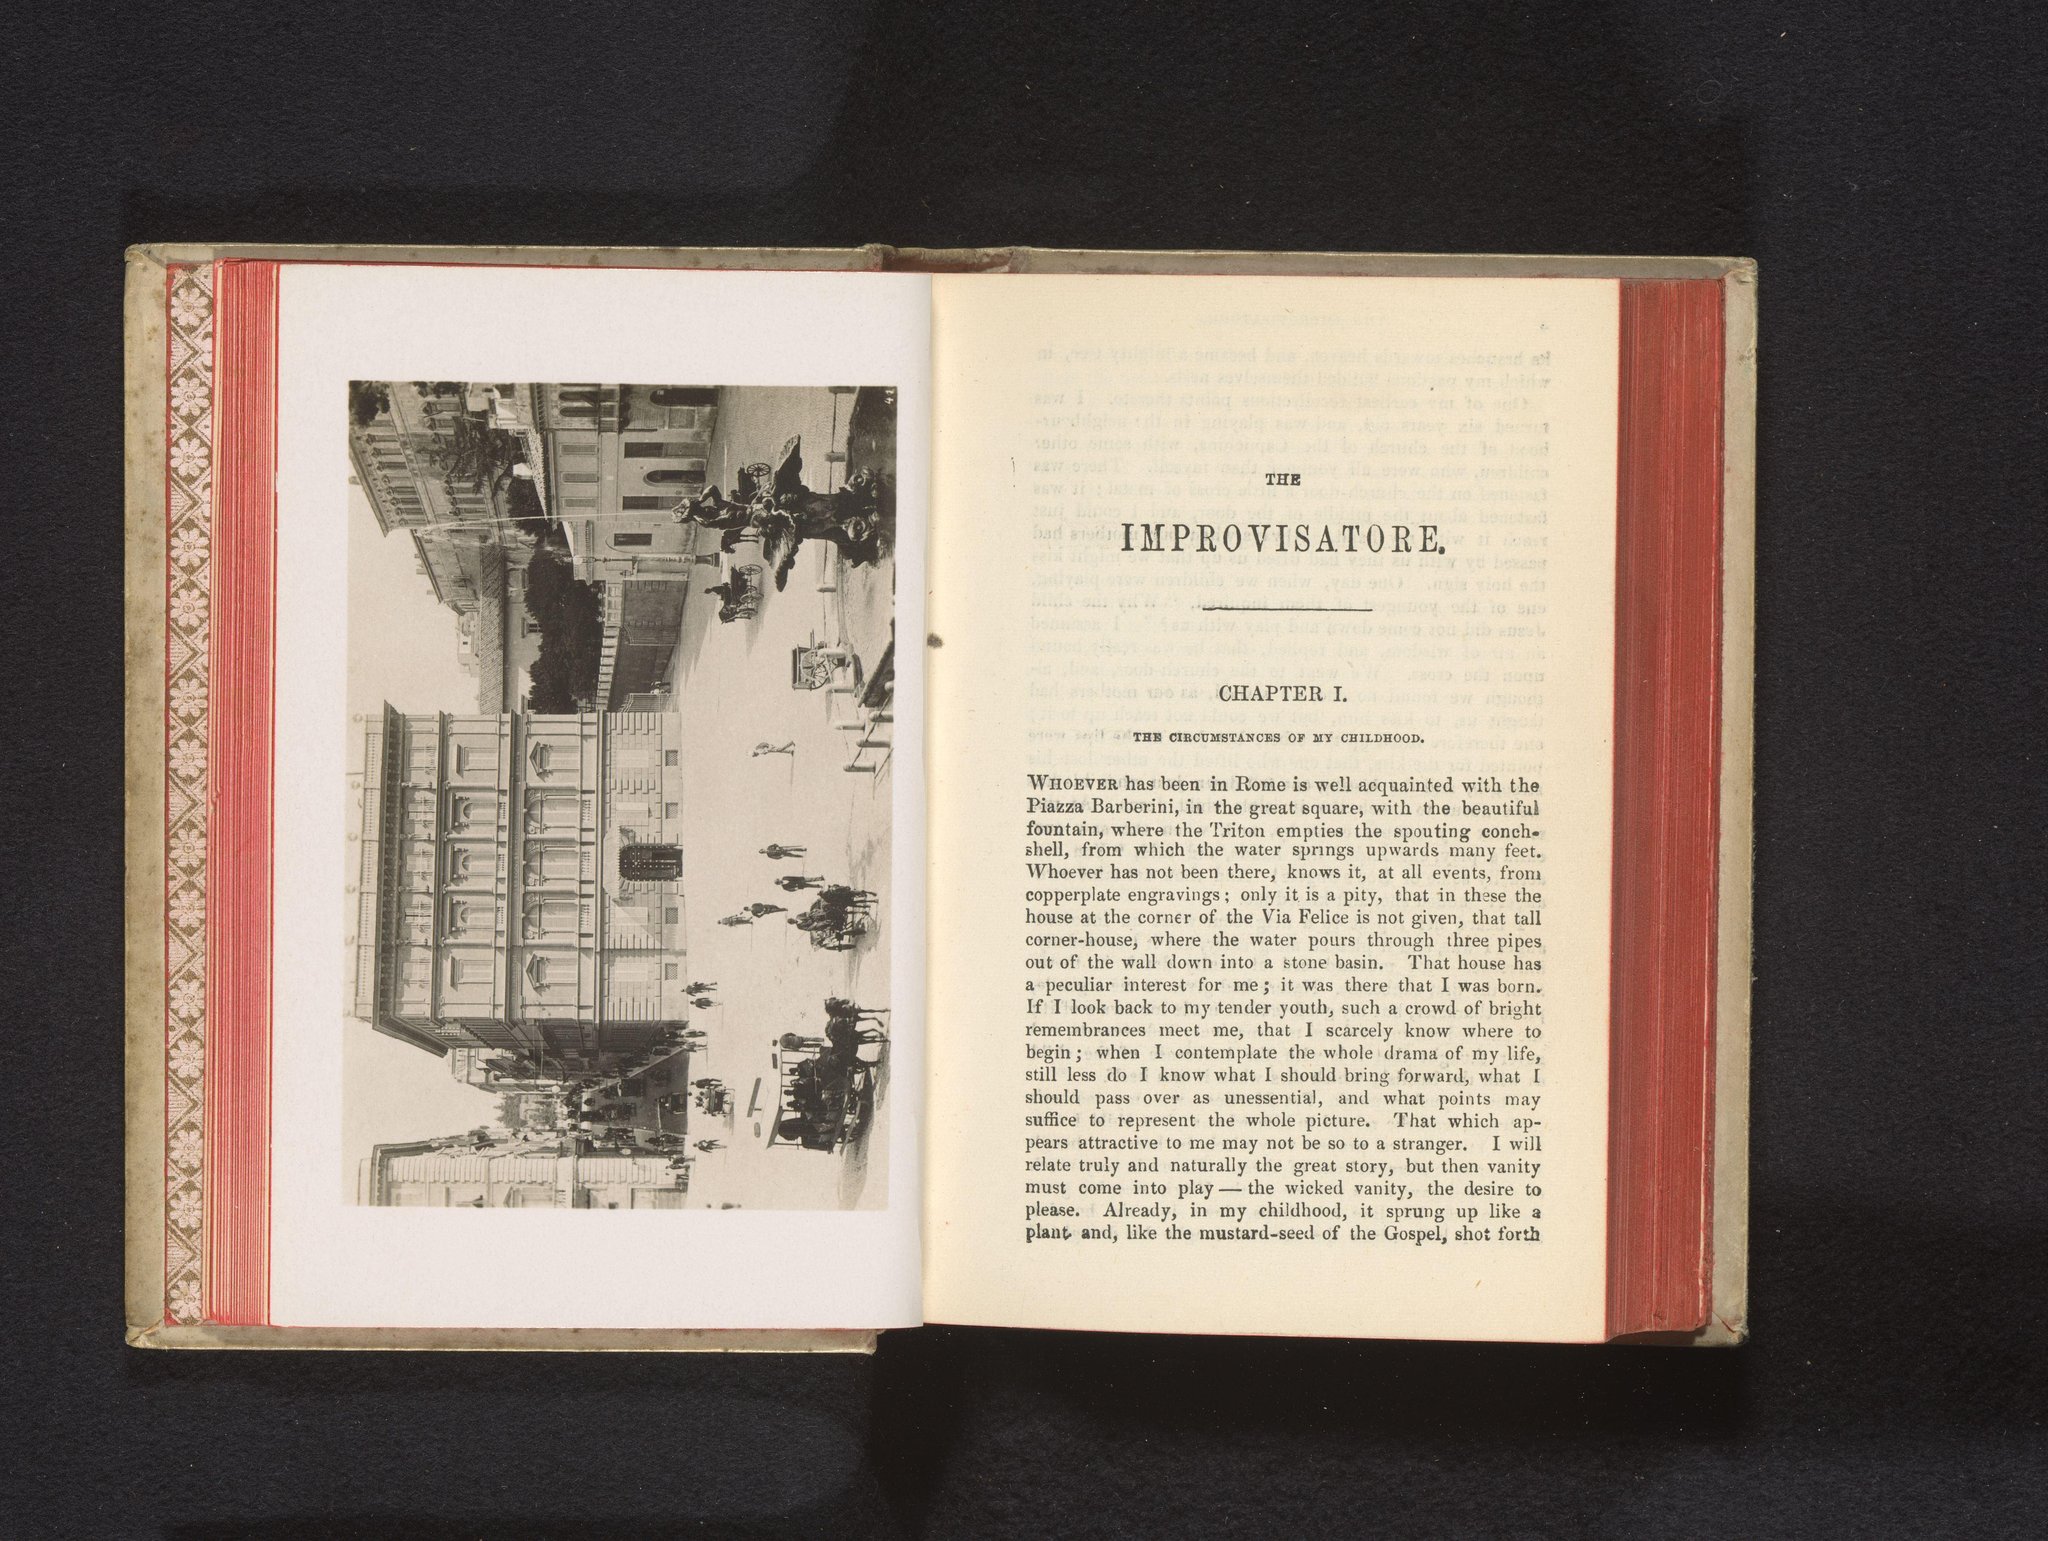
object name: photograph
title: Gezicht op het Piazza Barberini te Rome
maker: Anonymous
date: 1870-1880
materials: photographic support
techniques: gelatin silver print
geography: piazza barberini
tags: square, place, circus, etc., façade (of house or building)